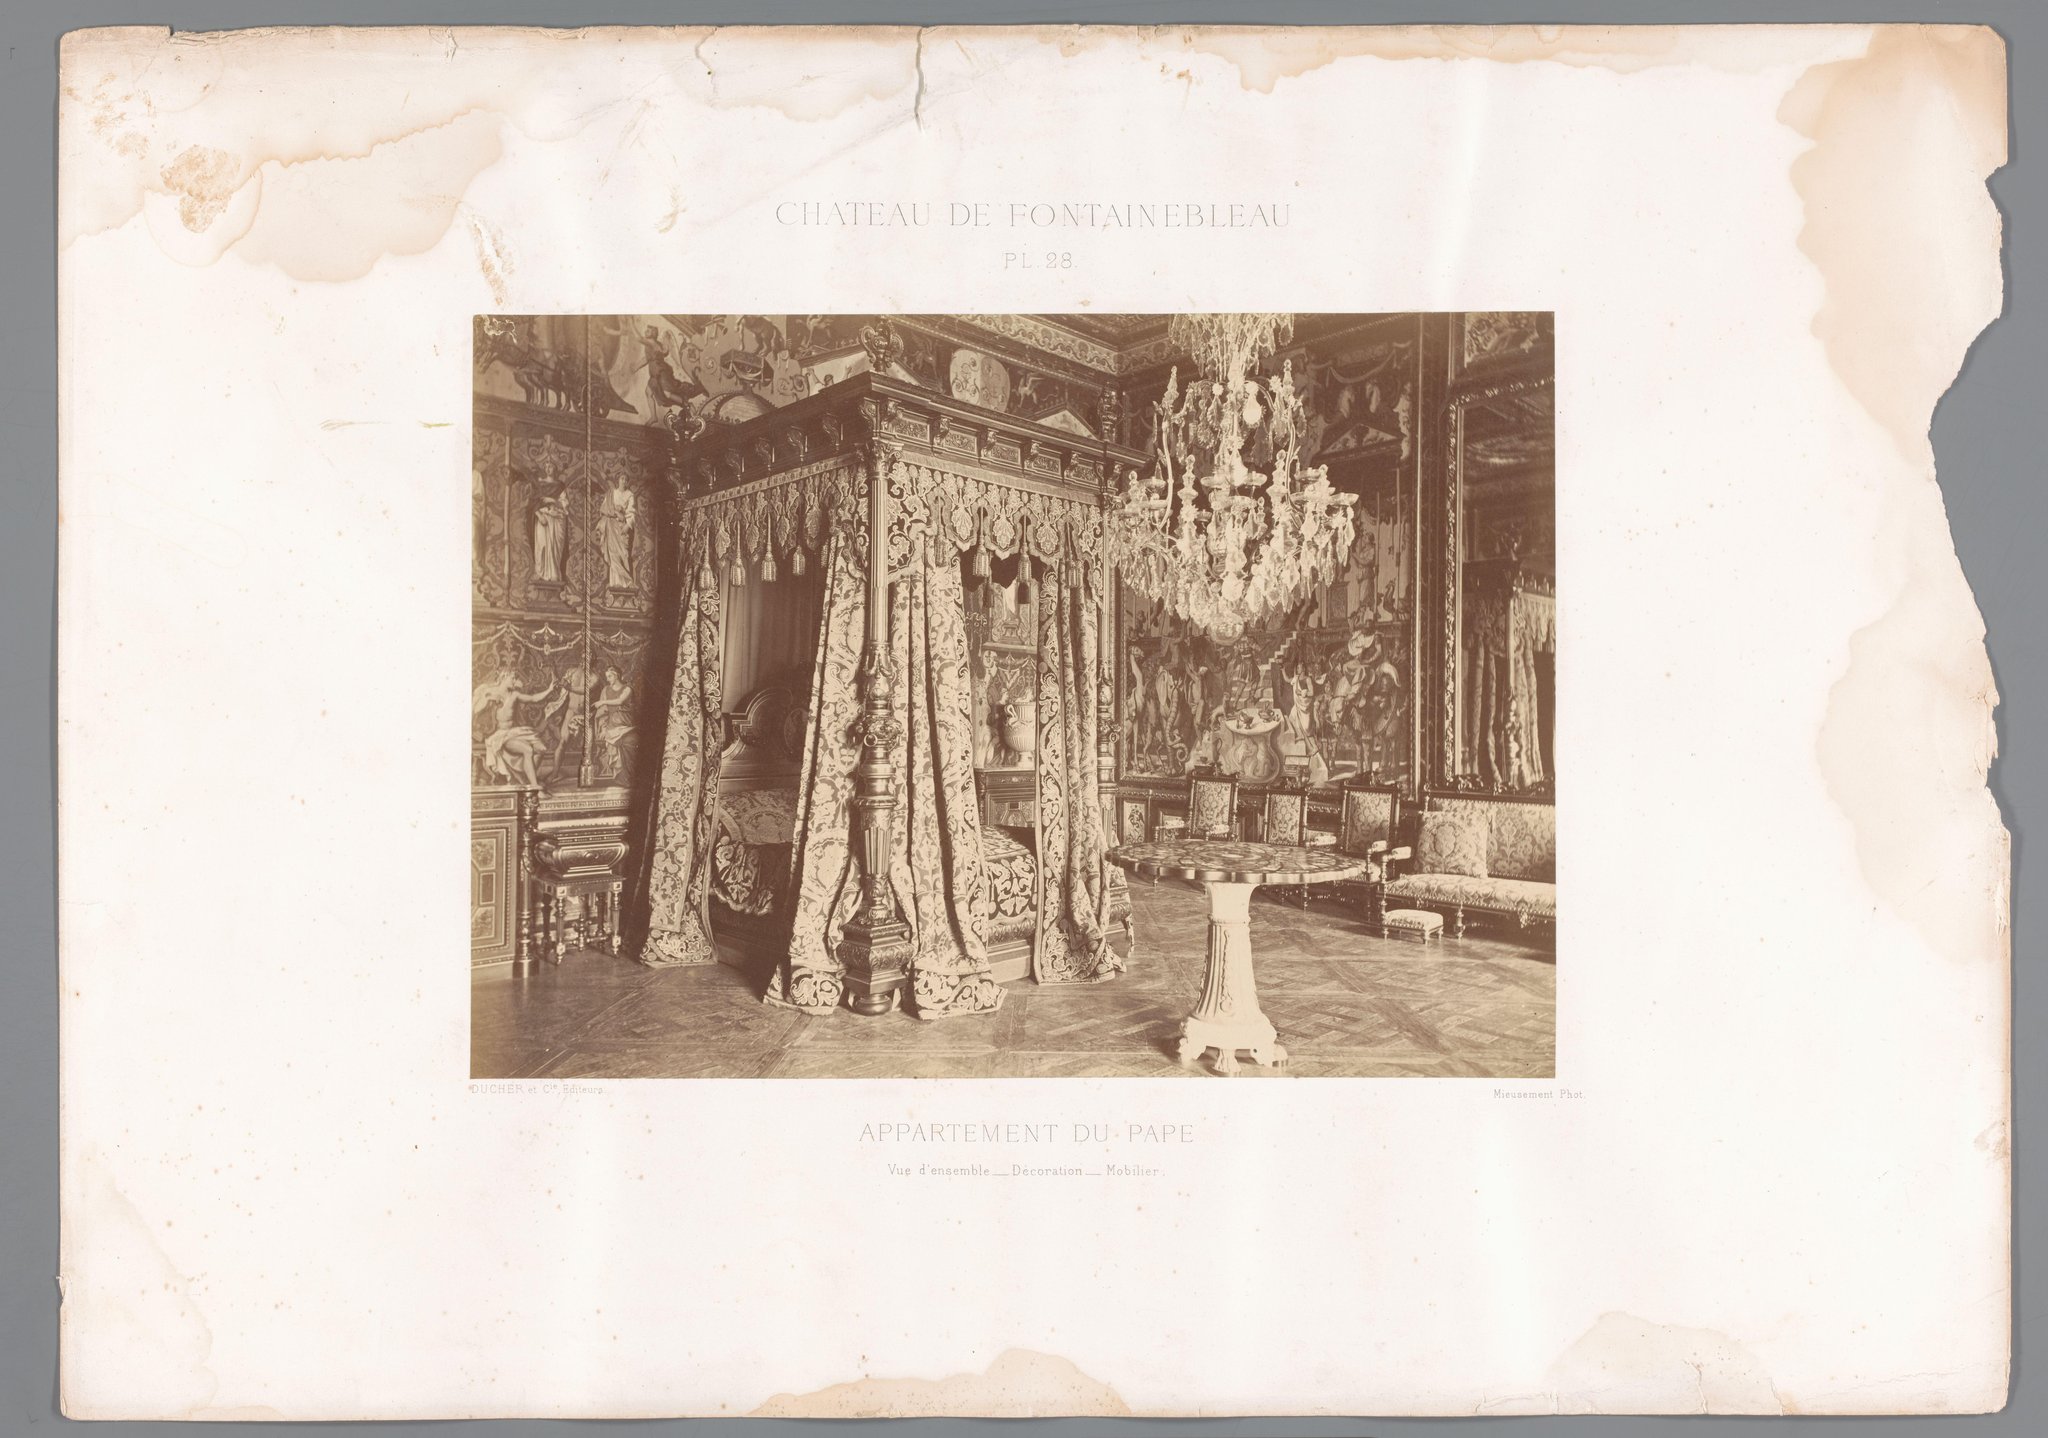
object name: photograph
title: Gezicht op het appartement voor paus Pius VII in het Kasteel van Fontainebleau, Frankrijk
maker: séraphin-médéric mieusement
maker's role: fotograaf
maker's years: 1840-1905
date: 1870-1875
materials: photographic support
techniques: albumen print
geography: fontainebleau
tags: castle - aa - civic architecture: inside, bedroom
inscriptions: number: ‘PL. 28.’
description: Deze foto maakt deel uit van een omslag met dertig foto's en twee tekstbladen.